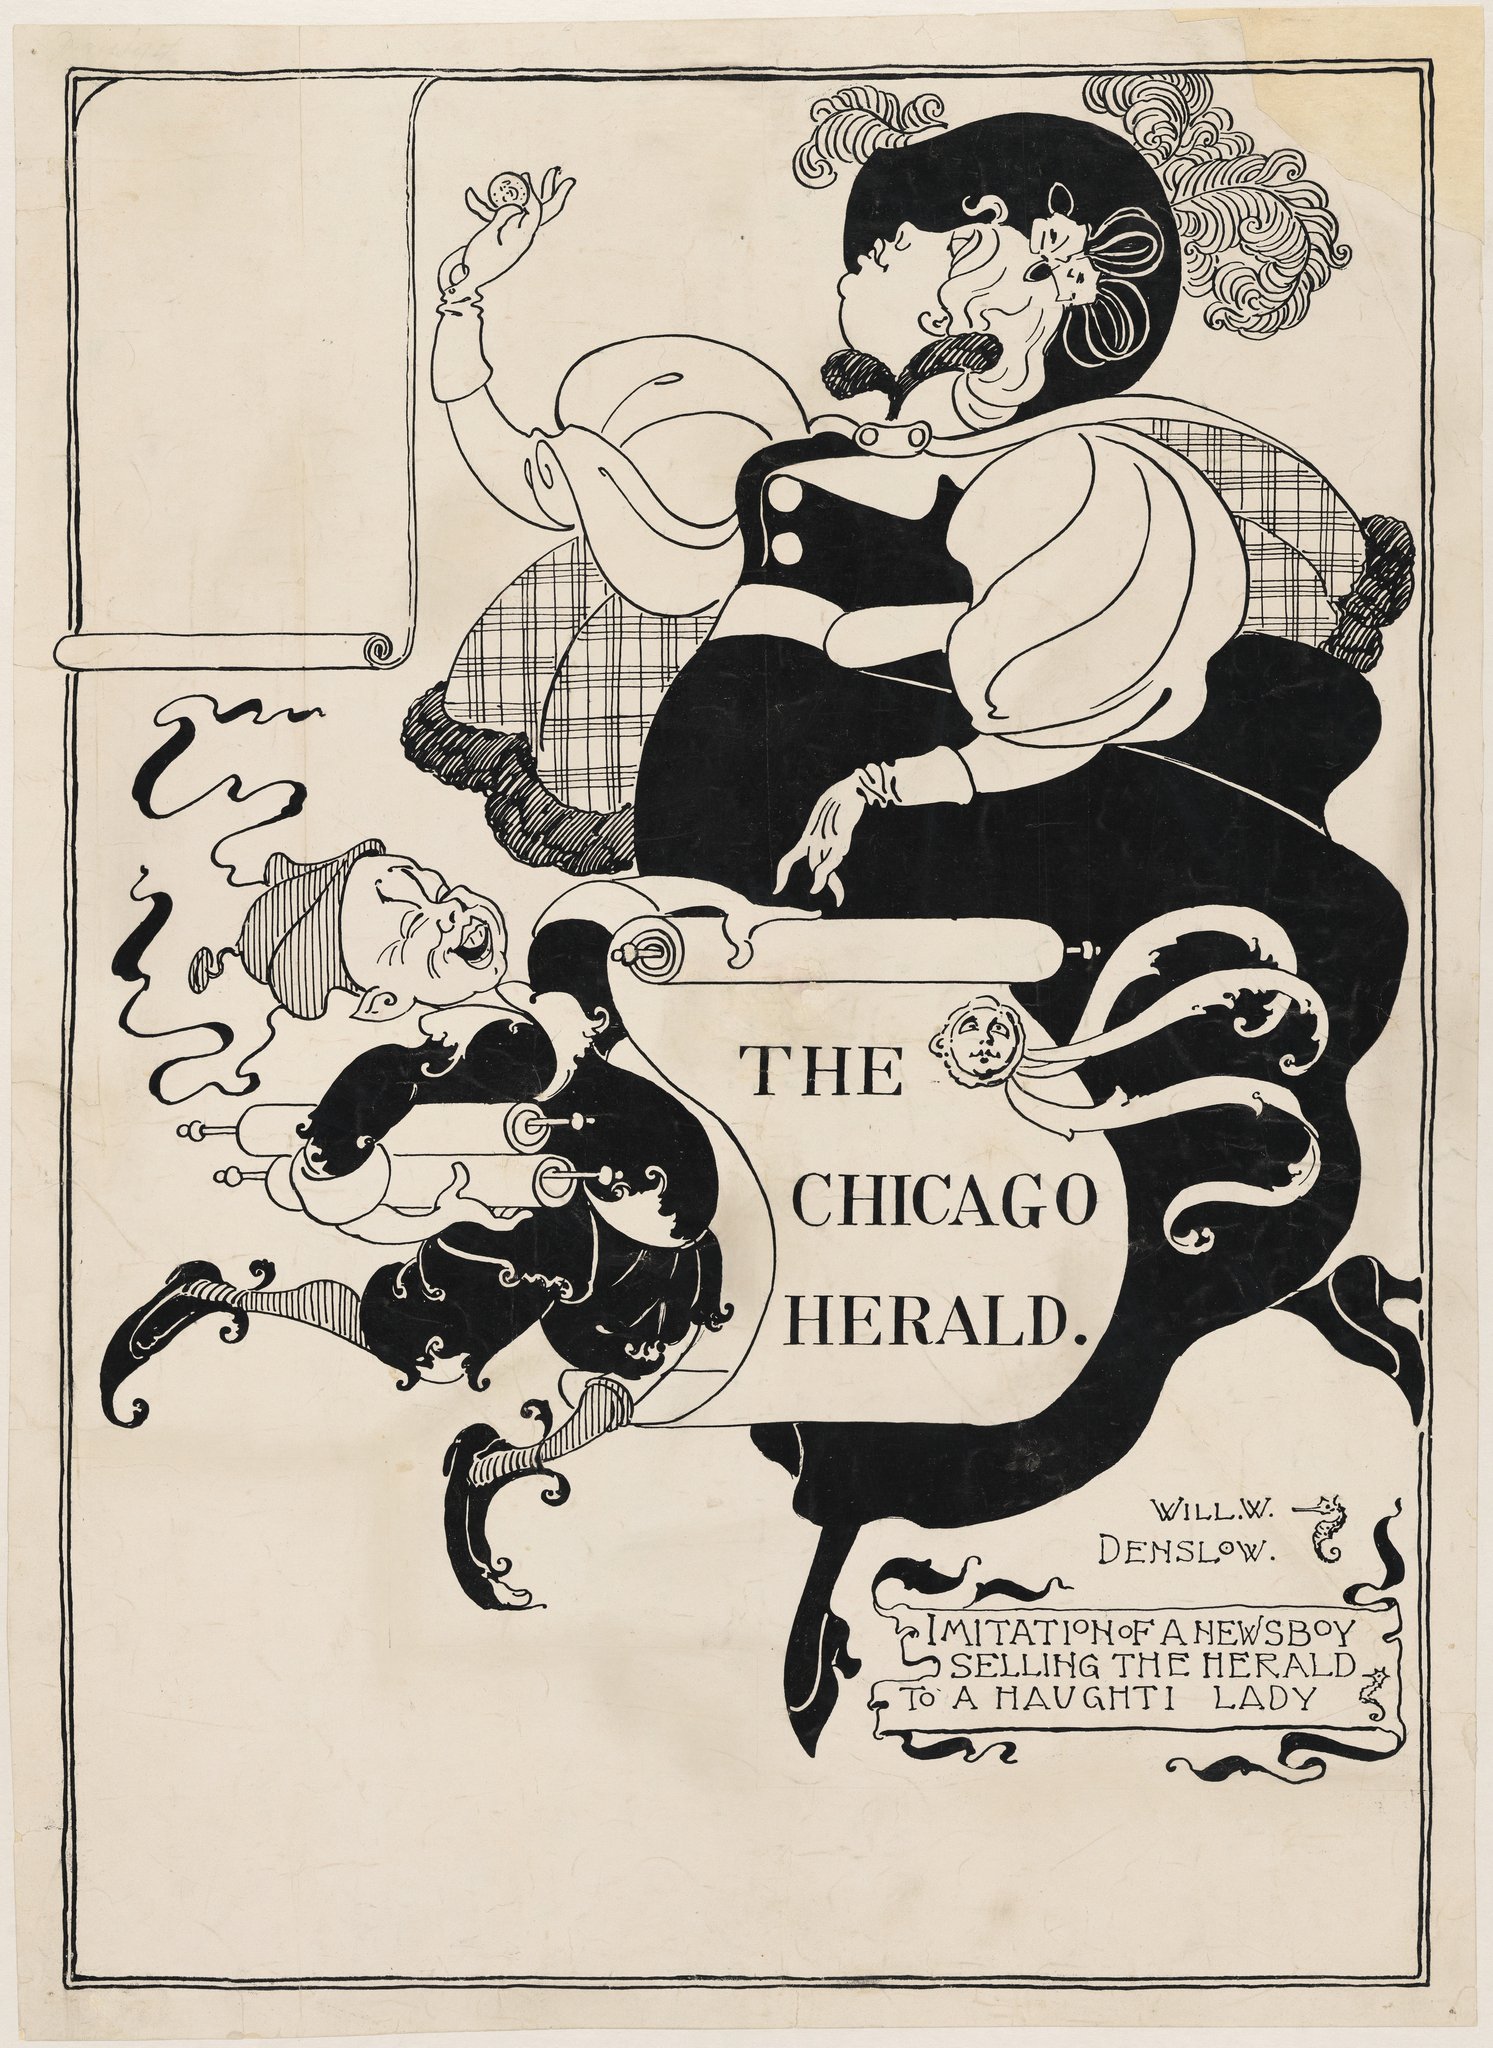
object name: print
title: The Chicago Herald, American Posters of the Turn of the Century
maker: william wallace denslow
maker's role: artist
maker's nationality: american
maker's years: 1856-1915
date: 1895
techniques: lithograph